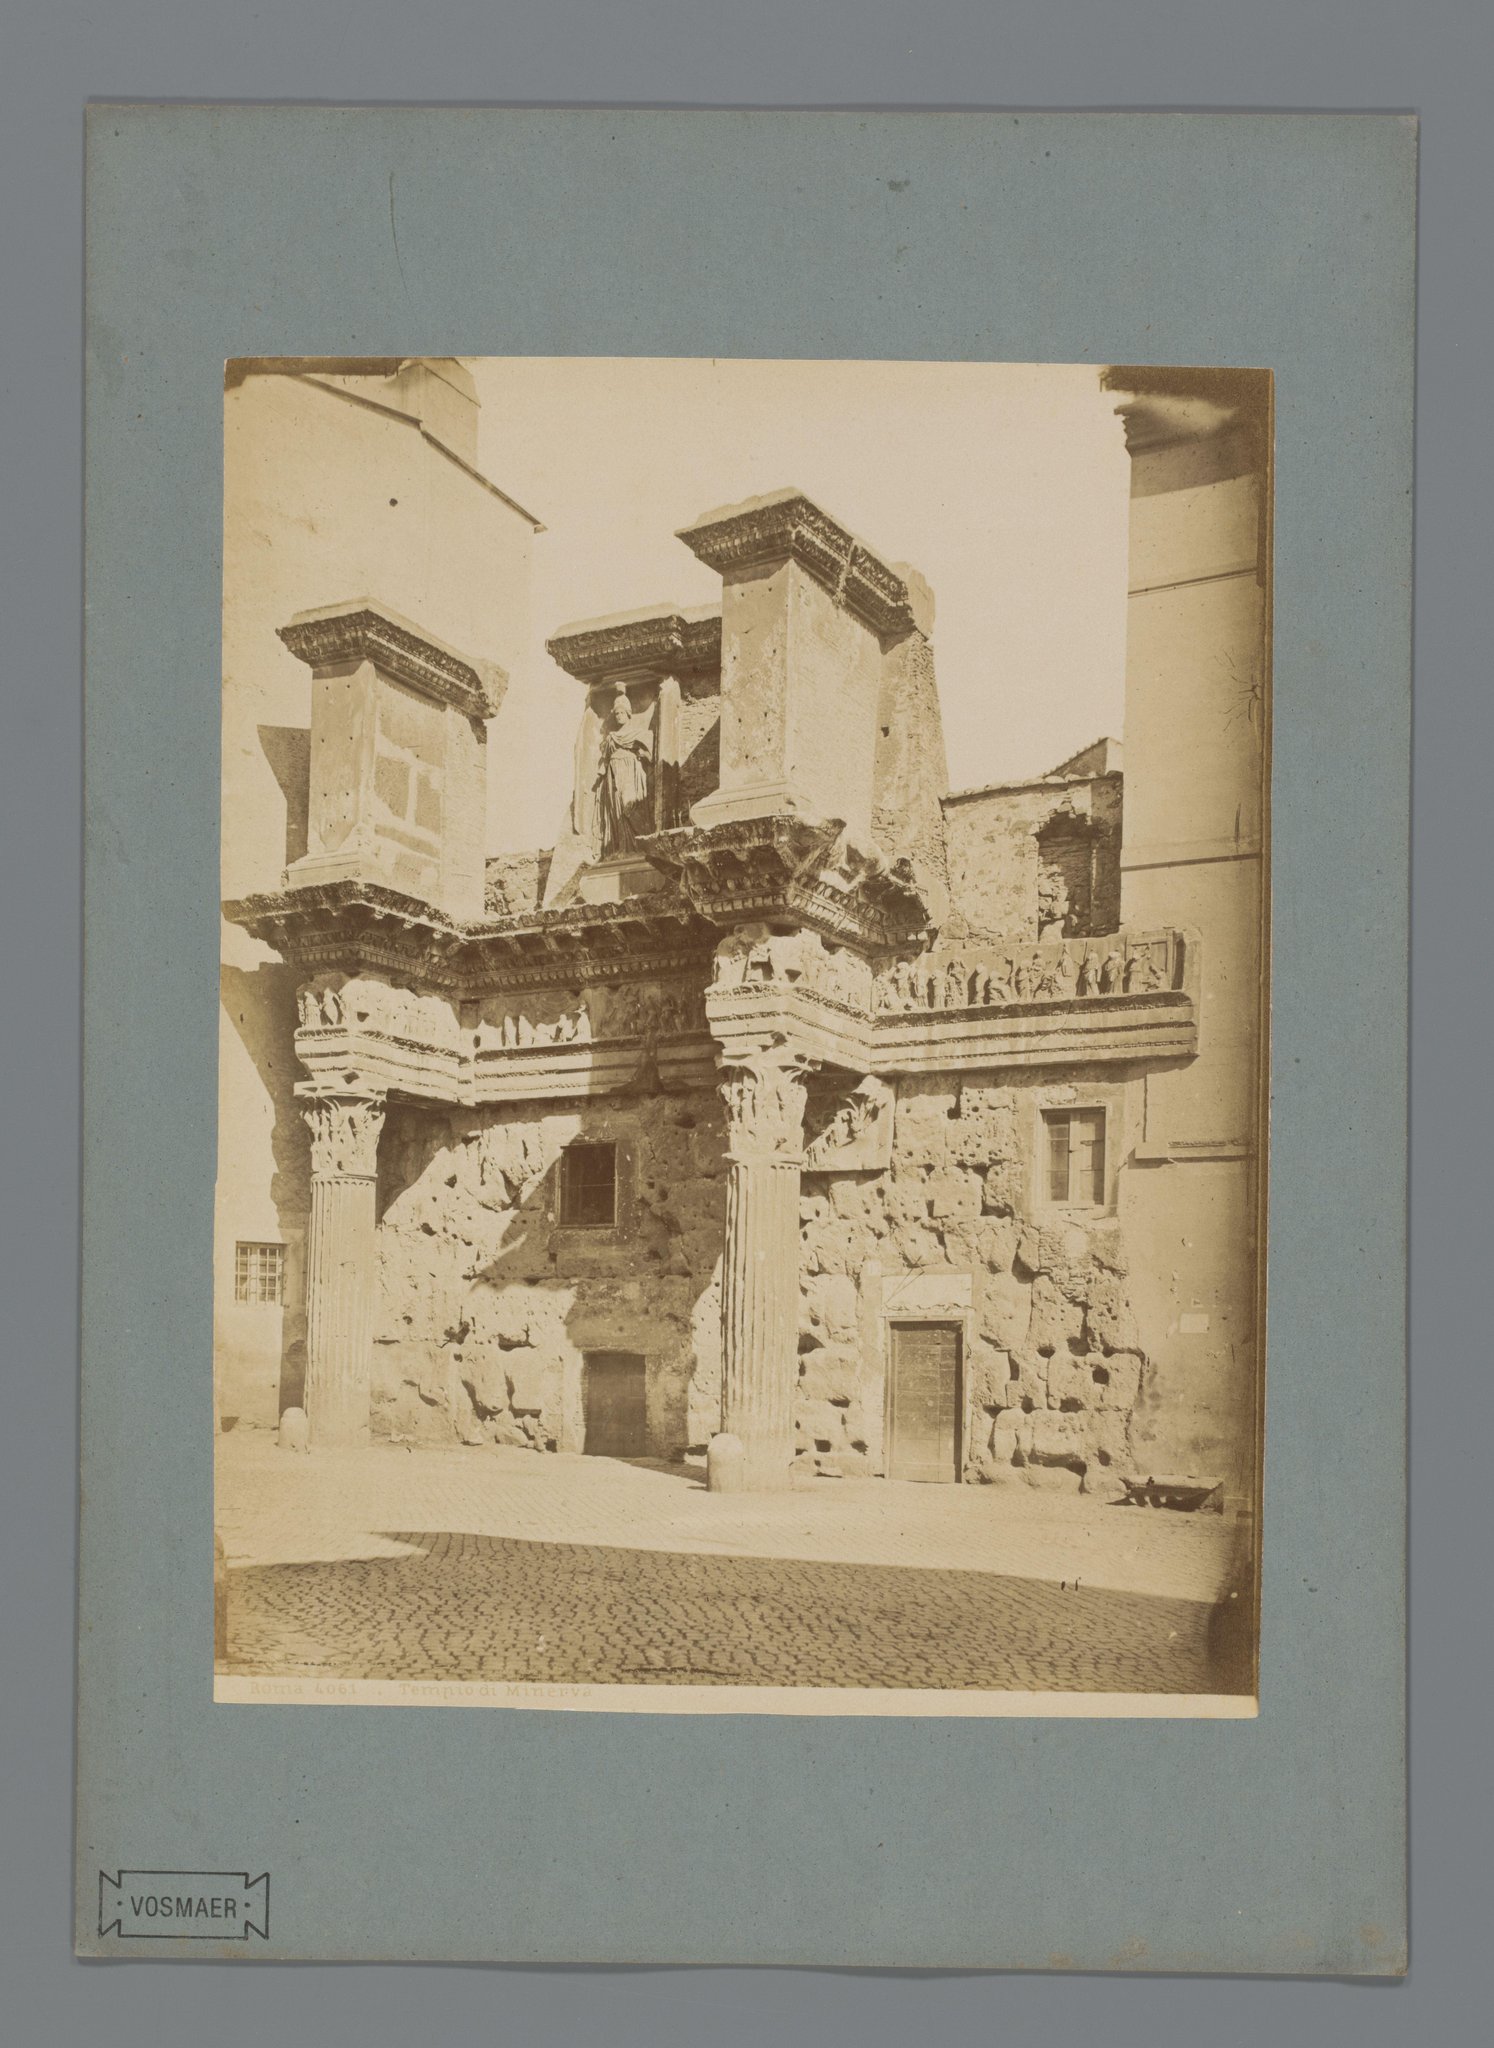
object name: photograph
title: Tempel van Minerva op het Forum van Nerva in Rome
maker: Anonymous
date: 1851-1900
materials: cardboard, paper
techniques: albumen print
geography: rome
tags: temple, shrine ~ roman religion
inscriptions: collector's mark: ‘VOSMAER’, number: ‘4061.’